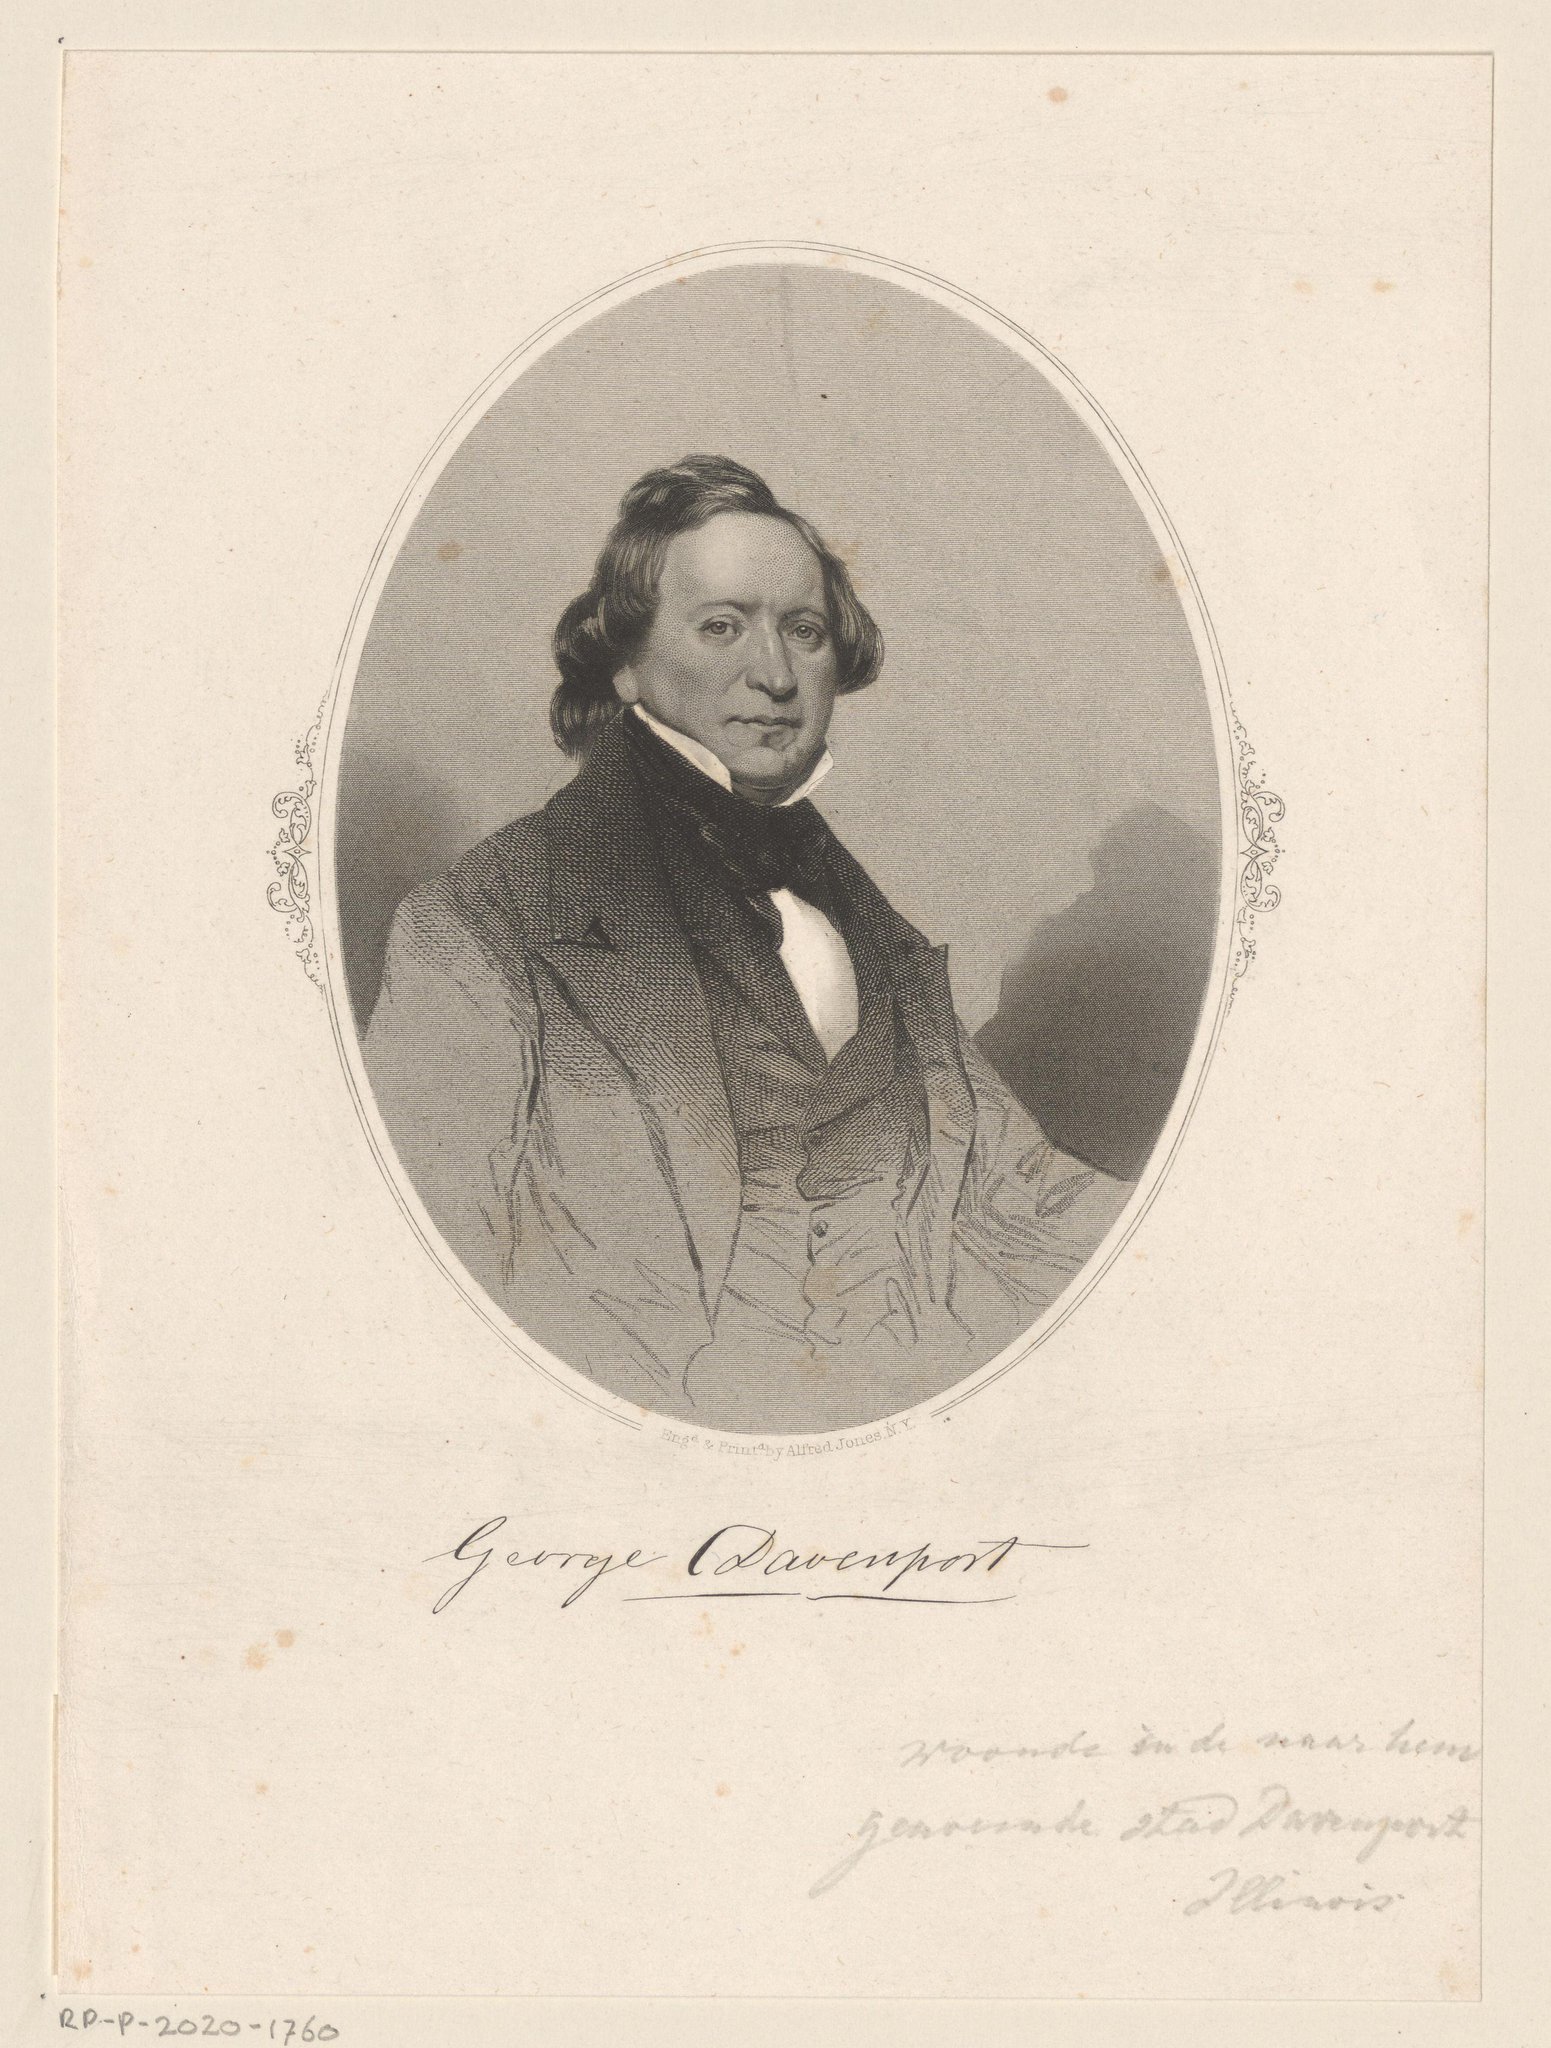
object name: print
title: Portret van George Davenport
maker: alfred jones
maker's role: print maker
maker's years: 1819-1900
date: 1845-1900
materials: paper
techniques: etching, engraving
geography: new york city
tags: urban housing, private soldier, historical persons, sailor, merchant, salesman